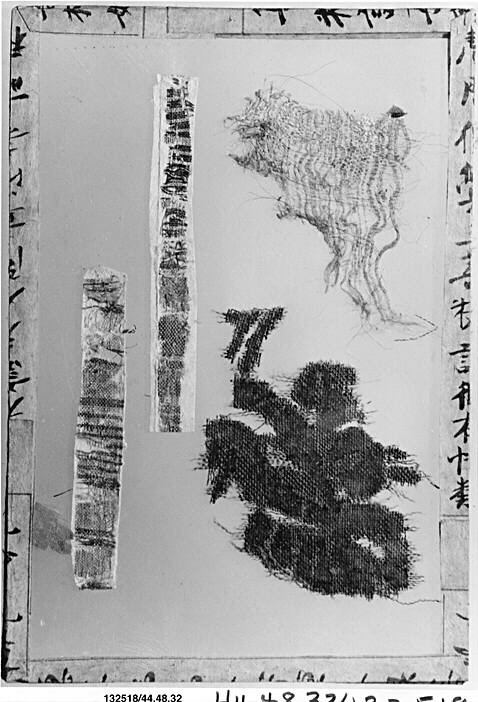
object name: fragment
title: Fragments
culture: japanese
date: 701-800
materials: cotton, linen, silk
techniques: painting